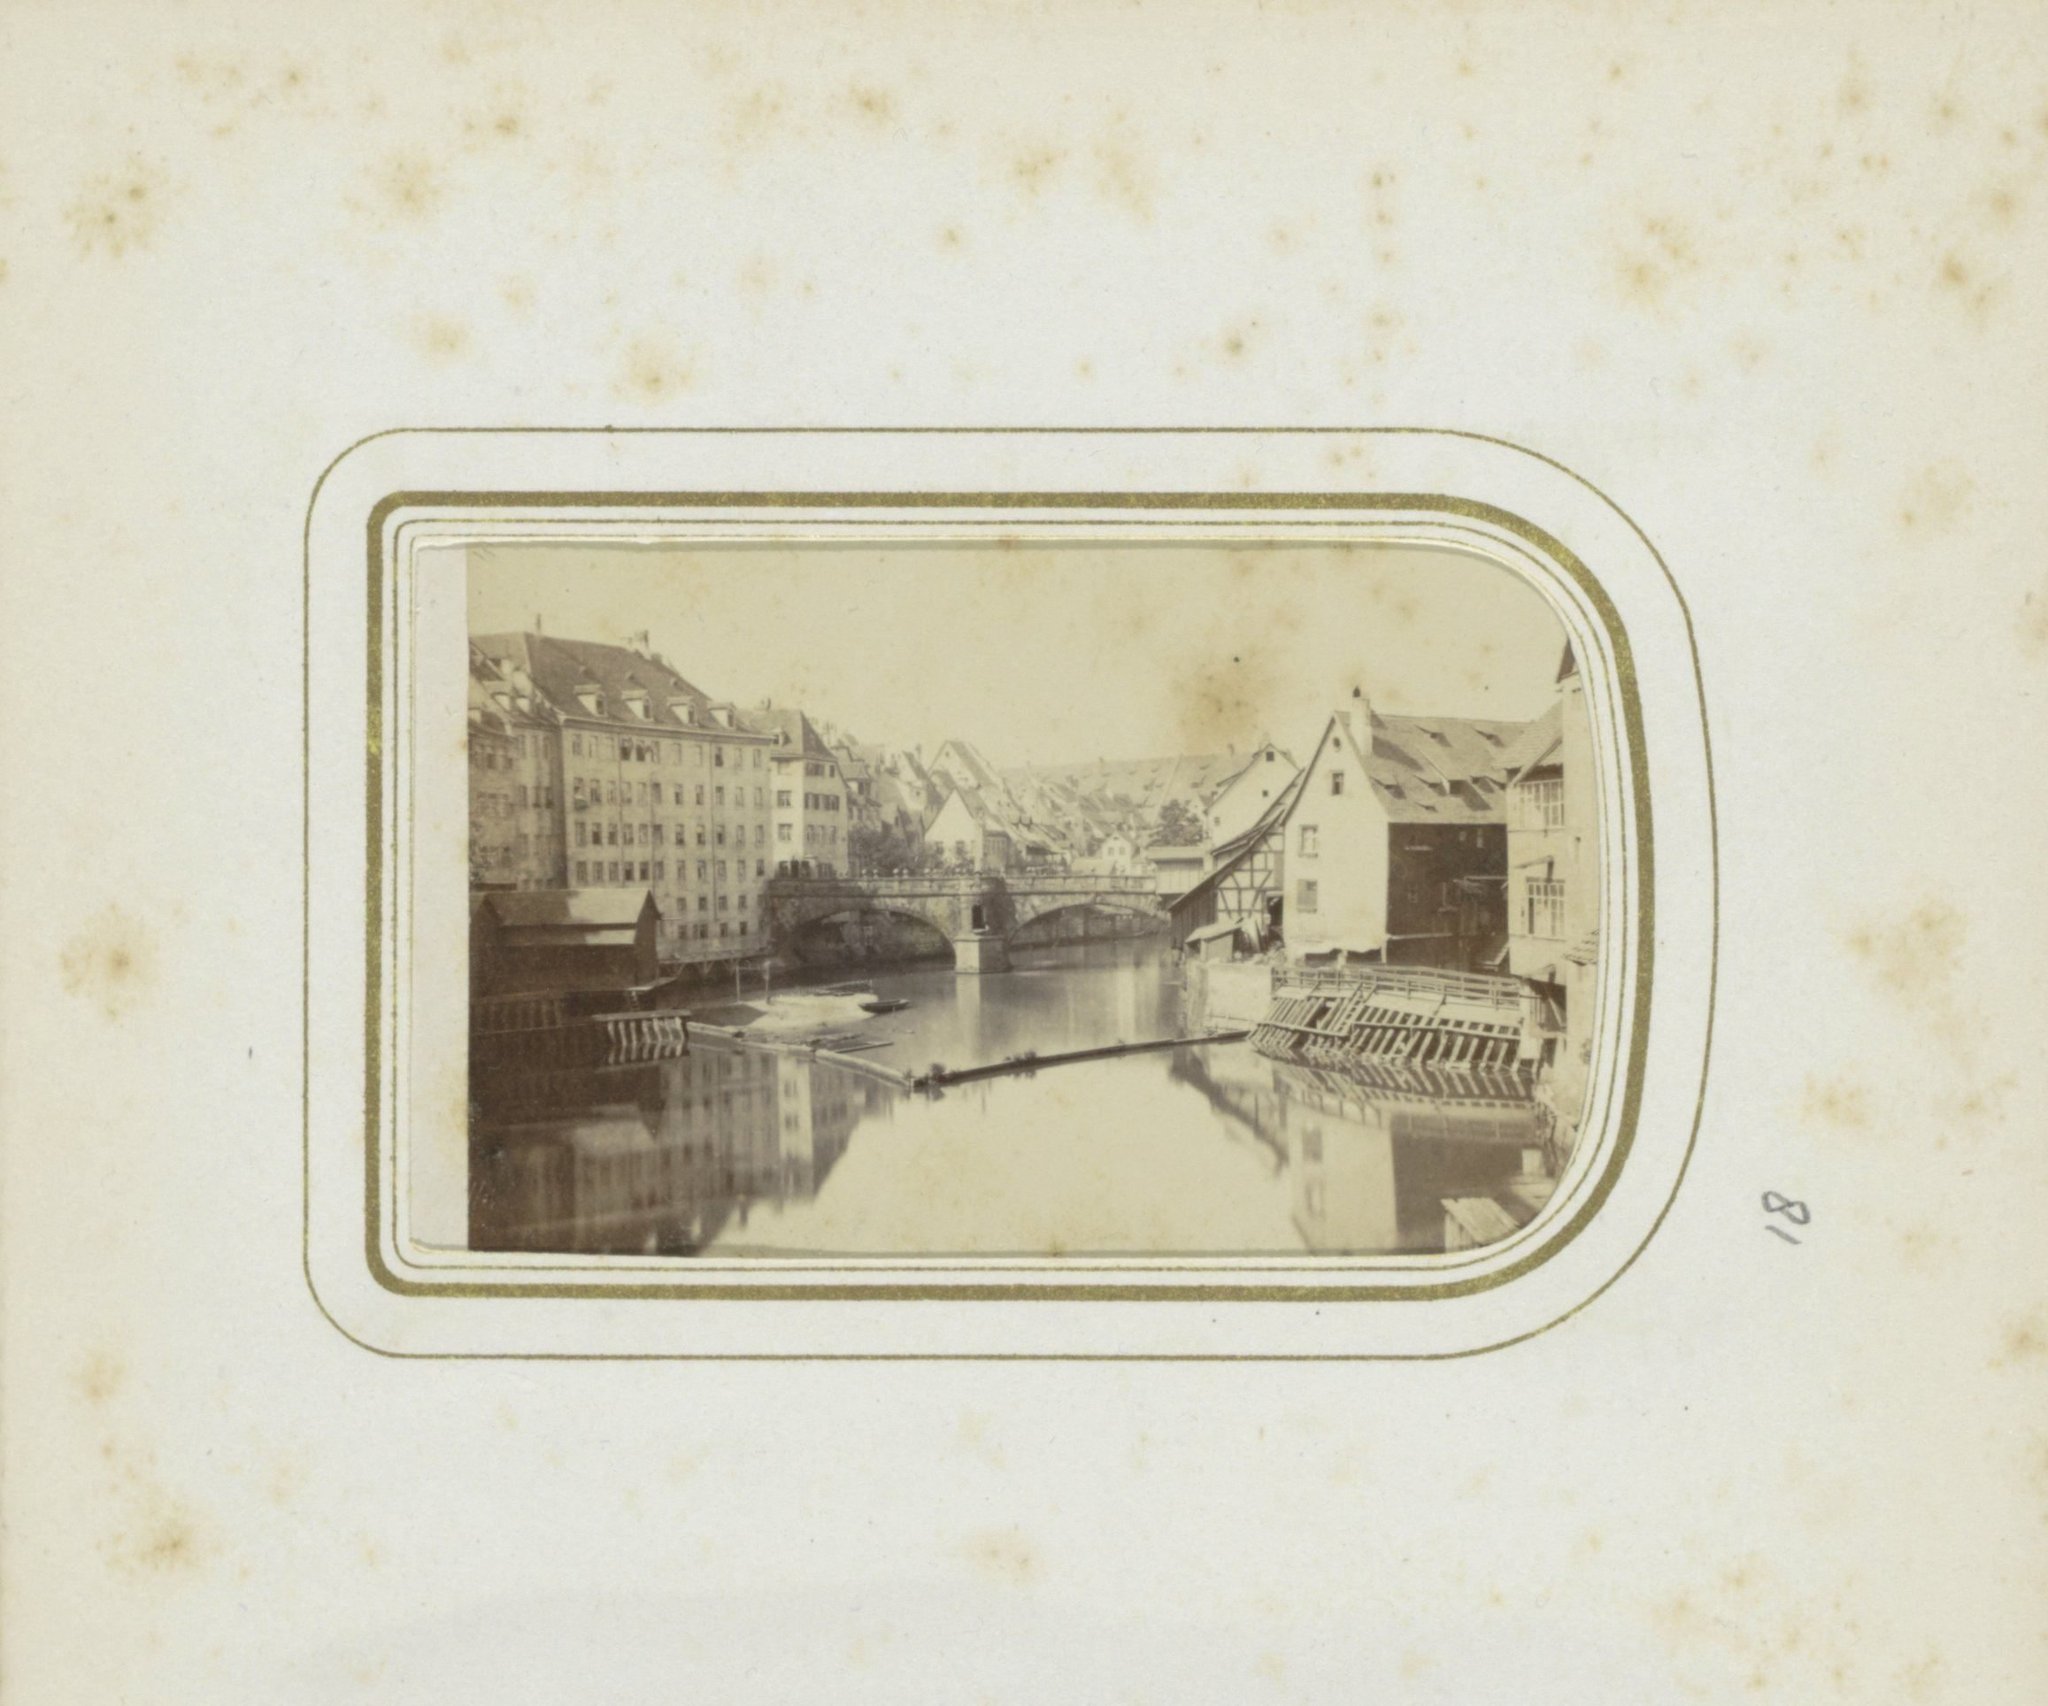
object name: photograph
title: Gezicht op Neurenberg over de rivier de Pegnitz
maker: Anonymous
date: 1865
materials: paper, photographic support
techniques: albumen print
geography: nuremberg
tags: river, waterfall, travelling; tourism, bridge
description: Onderdeel van Fotoalbum van een reis door Zwitserland, Oostenrijk en Duitsland door de Nederlandse familie Derkinderen.